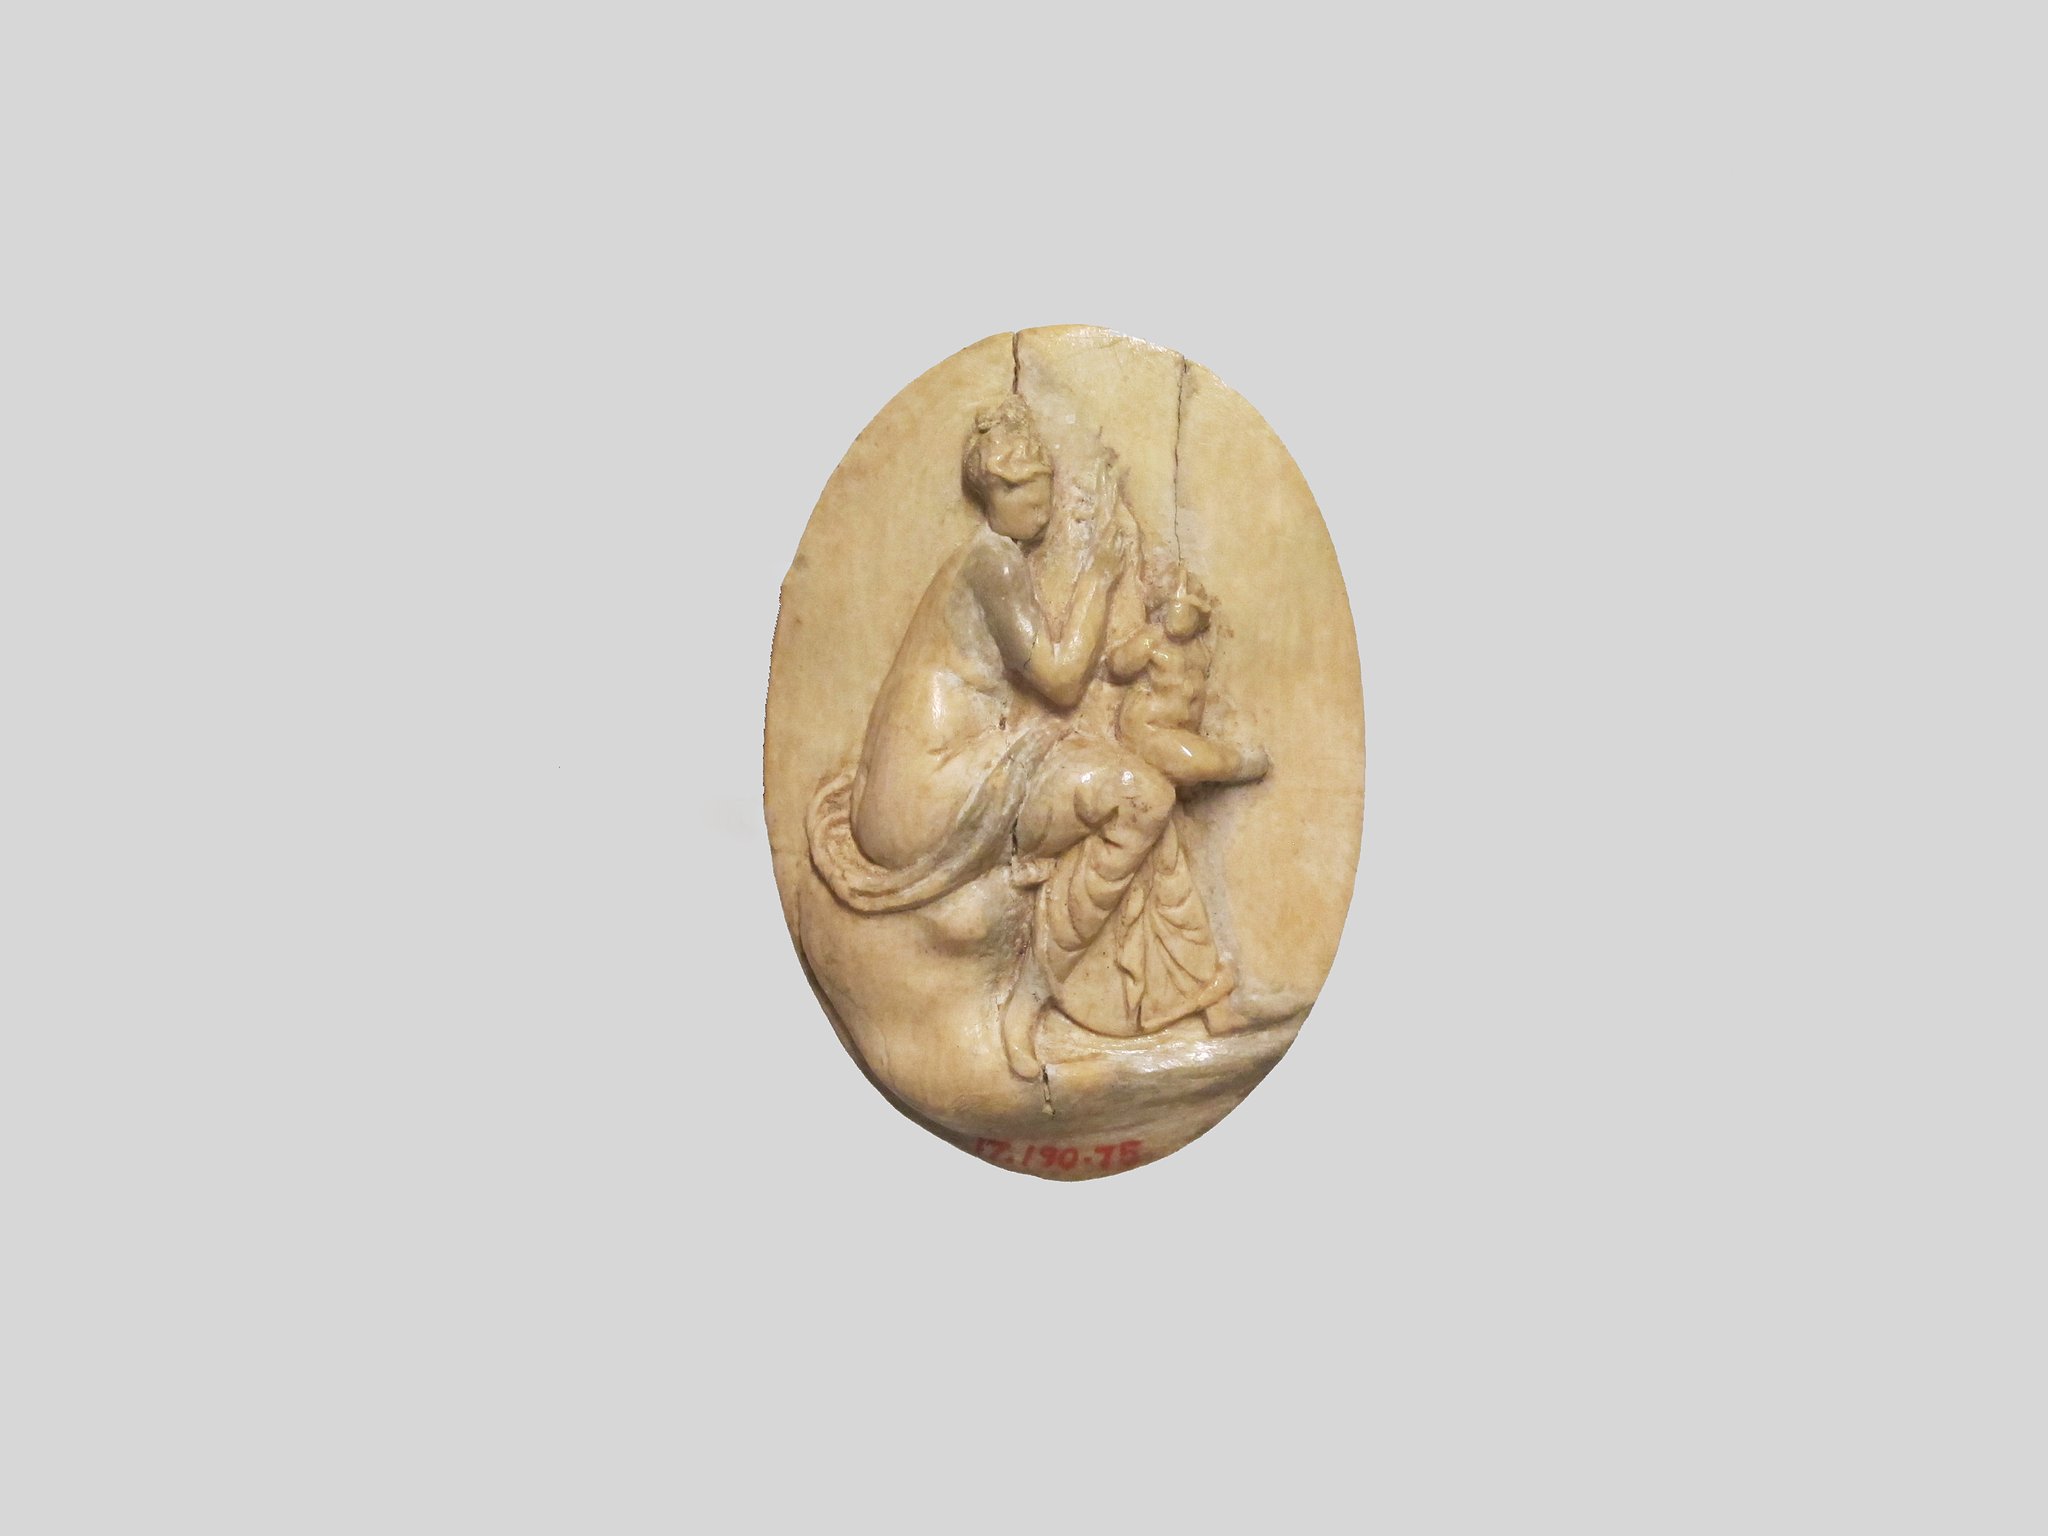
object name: ring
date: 7000 BCE-330 CE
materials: ivory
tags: human figures